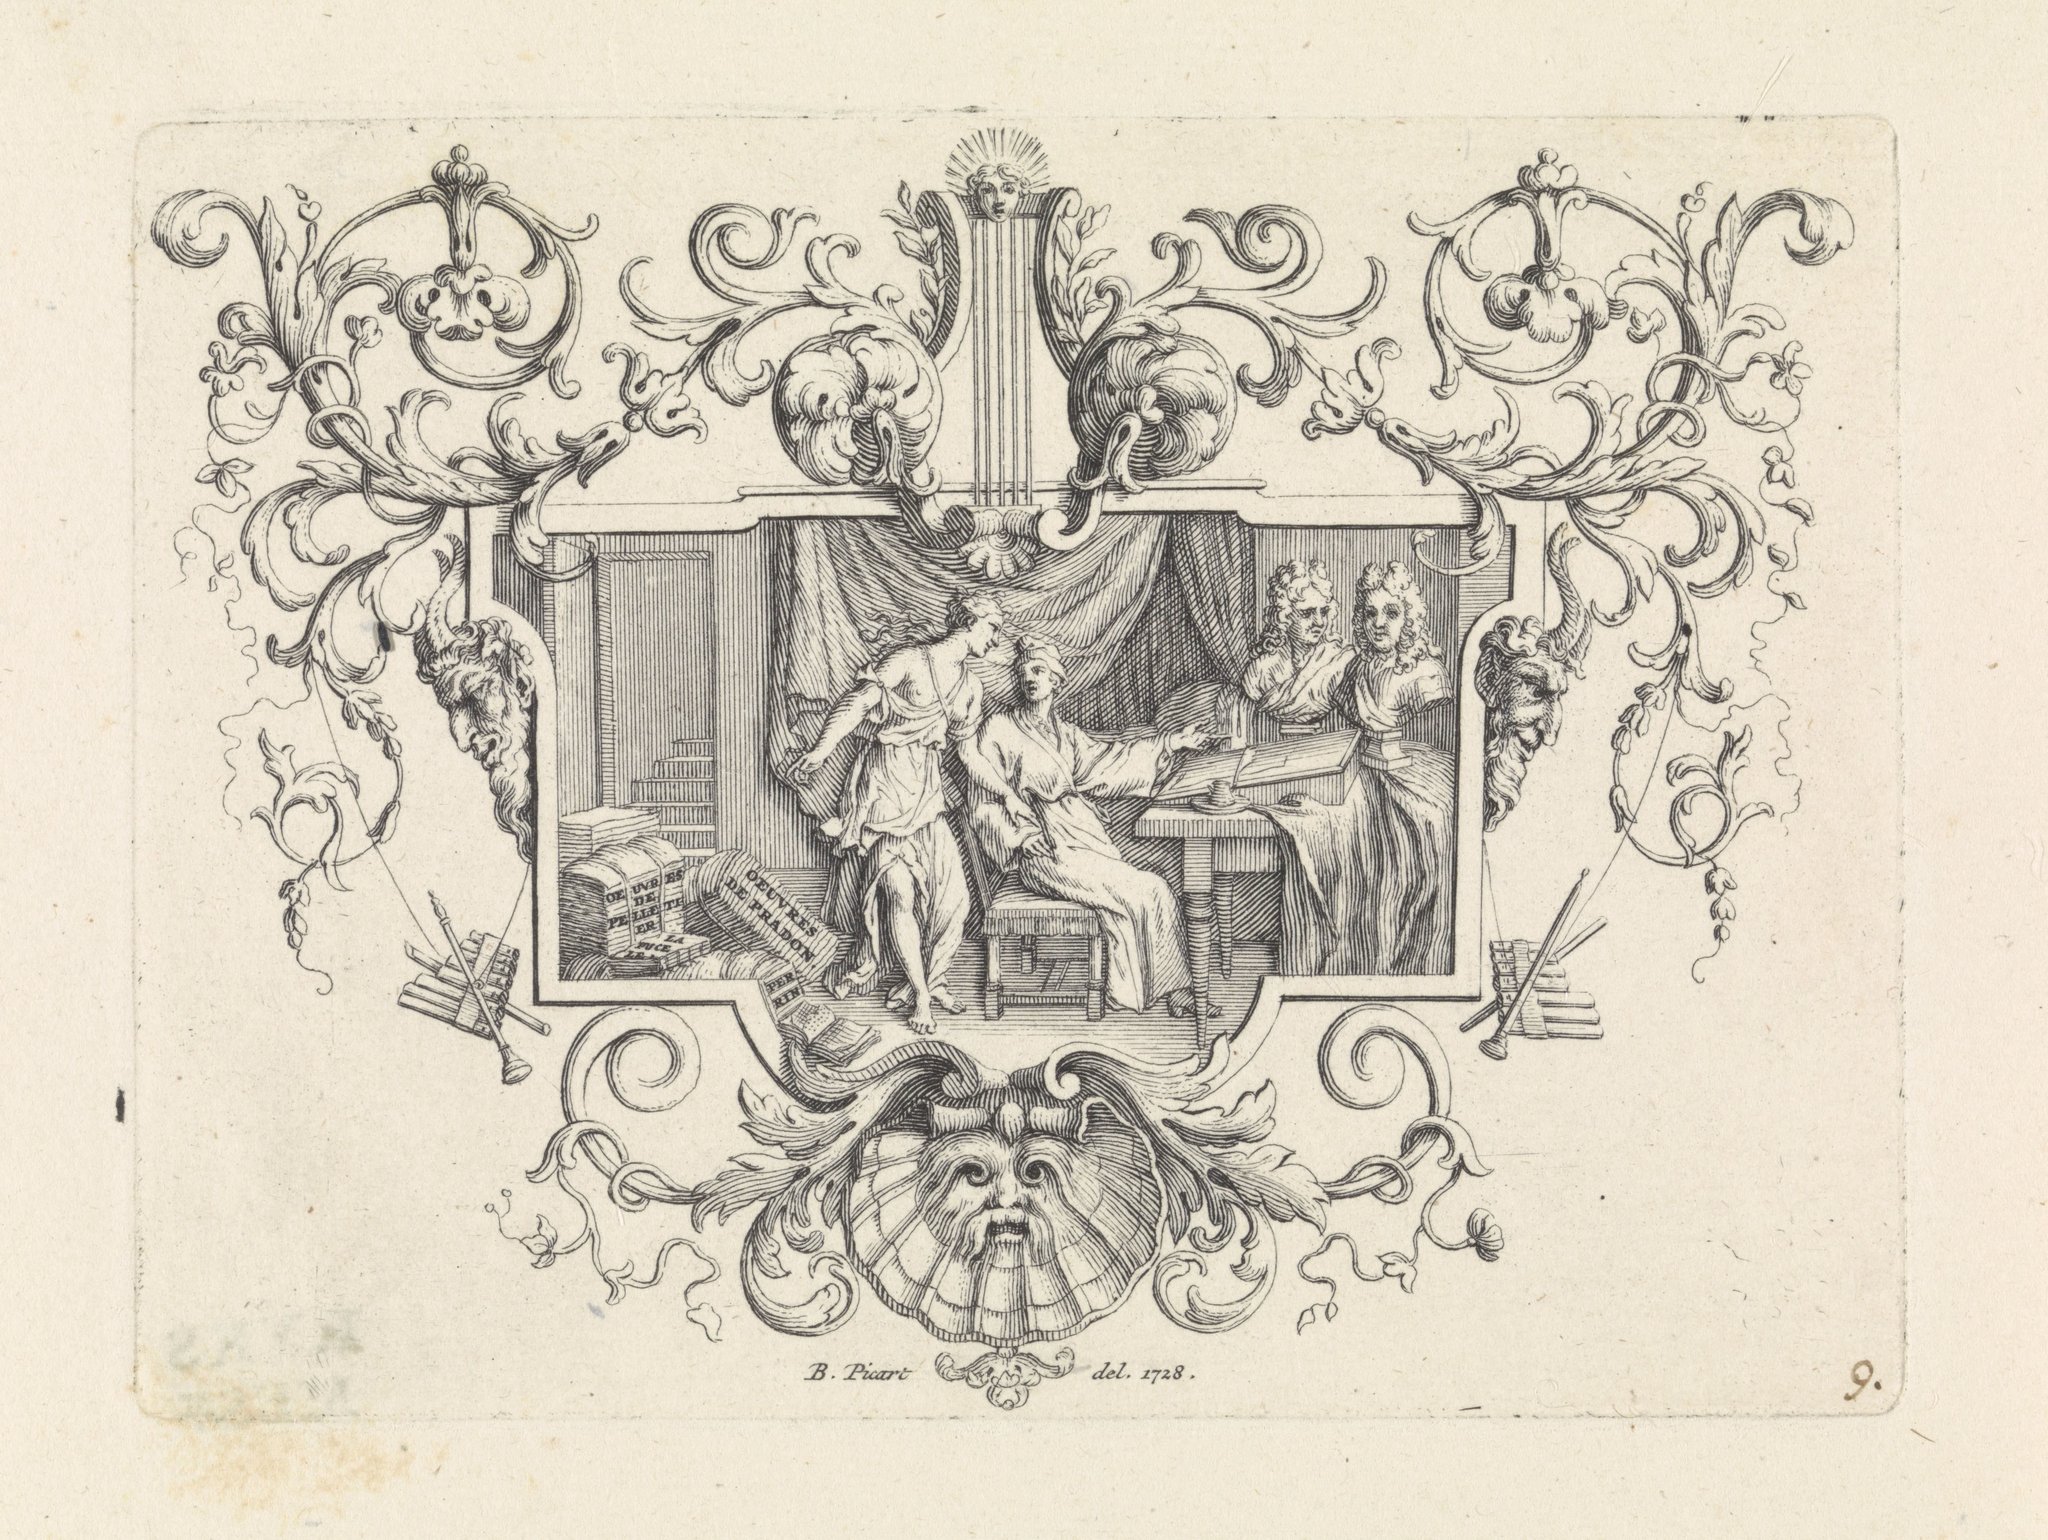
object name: print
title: Nicolas Boileau bij zijn bureau met zijn muze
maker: bernard picart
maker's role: draughtsman, print maker, publisher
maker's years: 1673-1733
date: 1728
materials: paper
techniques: engraving, etching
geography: amsterdam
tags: paris, nicolas boileau, ornaments ~ art, (story of the) muses; 'muse' (ripa), book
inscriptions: collector's mark: Lugt 2165, number: ‘9.’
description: Prent mogelijk gebruikt in: Boileau-Despréaux, Nicolas. Oeuvres. Amsterdam: François Changuion, Den Haag, Pieter de Hondt, 1729. Nummer 9 in: Explication des Vignettes de la Seconde Edition des Oeuvres de Boileau. Amsterdam: Bernard Picart, 1729.